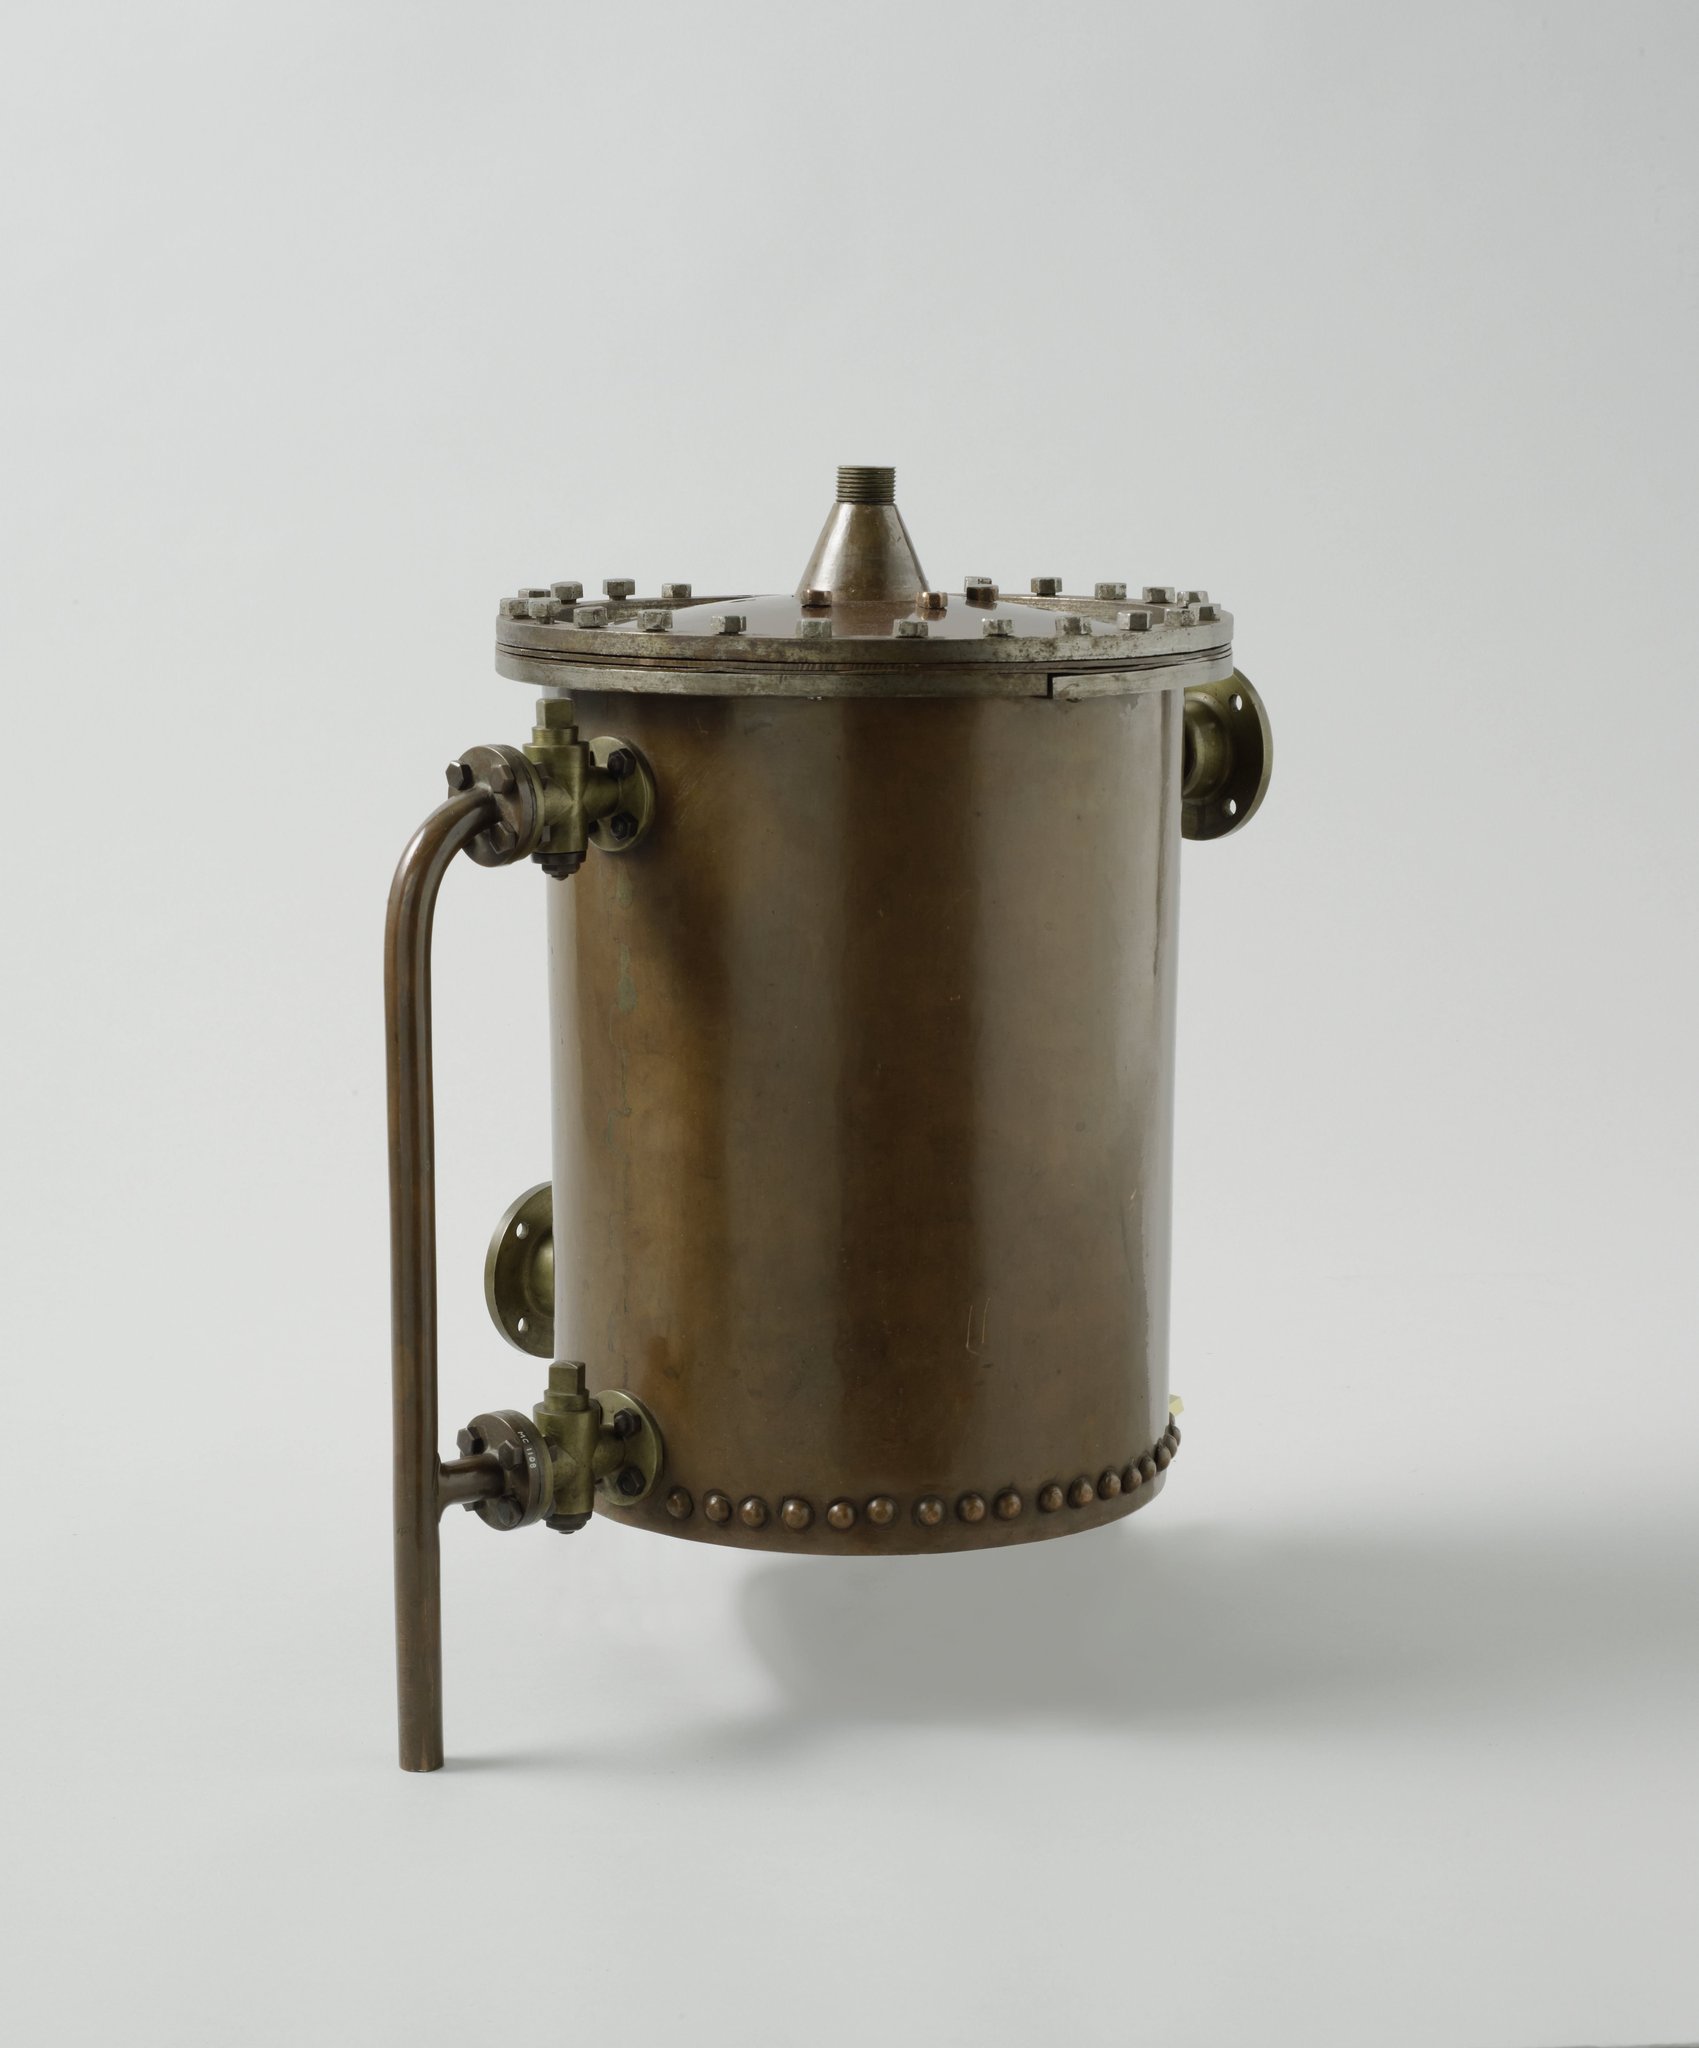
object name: condensor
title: Distilling Apparatus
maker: Anonymous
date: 1866-1870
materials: brass, copper, iron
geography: united kingdom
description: Distilleerapparaat of condensor voor het verkrijgen van zoet water uit zout water, met handgeschreven uitleg op papier (NG-MC-1108-2). Het systeem heeft twee gescheiden waterstromen: koud zeewater van buiten het schip komt het uitwendige, cylindrische vat beneden binnen en, verhit, verlaat het apparaat langs boven en wordt weer buiten het schip geleid; stoom wordt door de bovenkant het apparaat ingeleid en verdeeld in een aantal pijpen, waarin het wordt gekoeld door het zeewater in het uitwendige vat en, eenmaal gecondenseerd, wordt het onder als zoet water afgetapt. In de wand van het uitwendige vat zijn nog twee kranen aangebracht, aangesloten op een leiding. De afsluitingen van het uitwendige vat en van de distilleerpijpen zijn met bouten en moeren aangebracht.